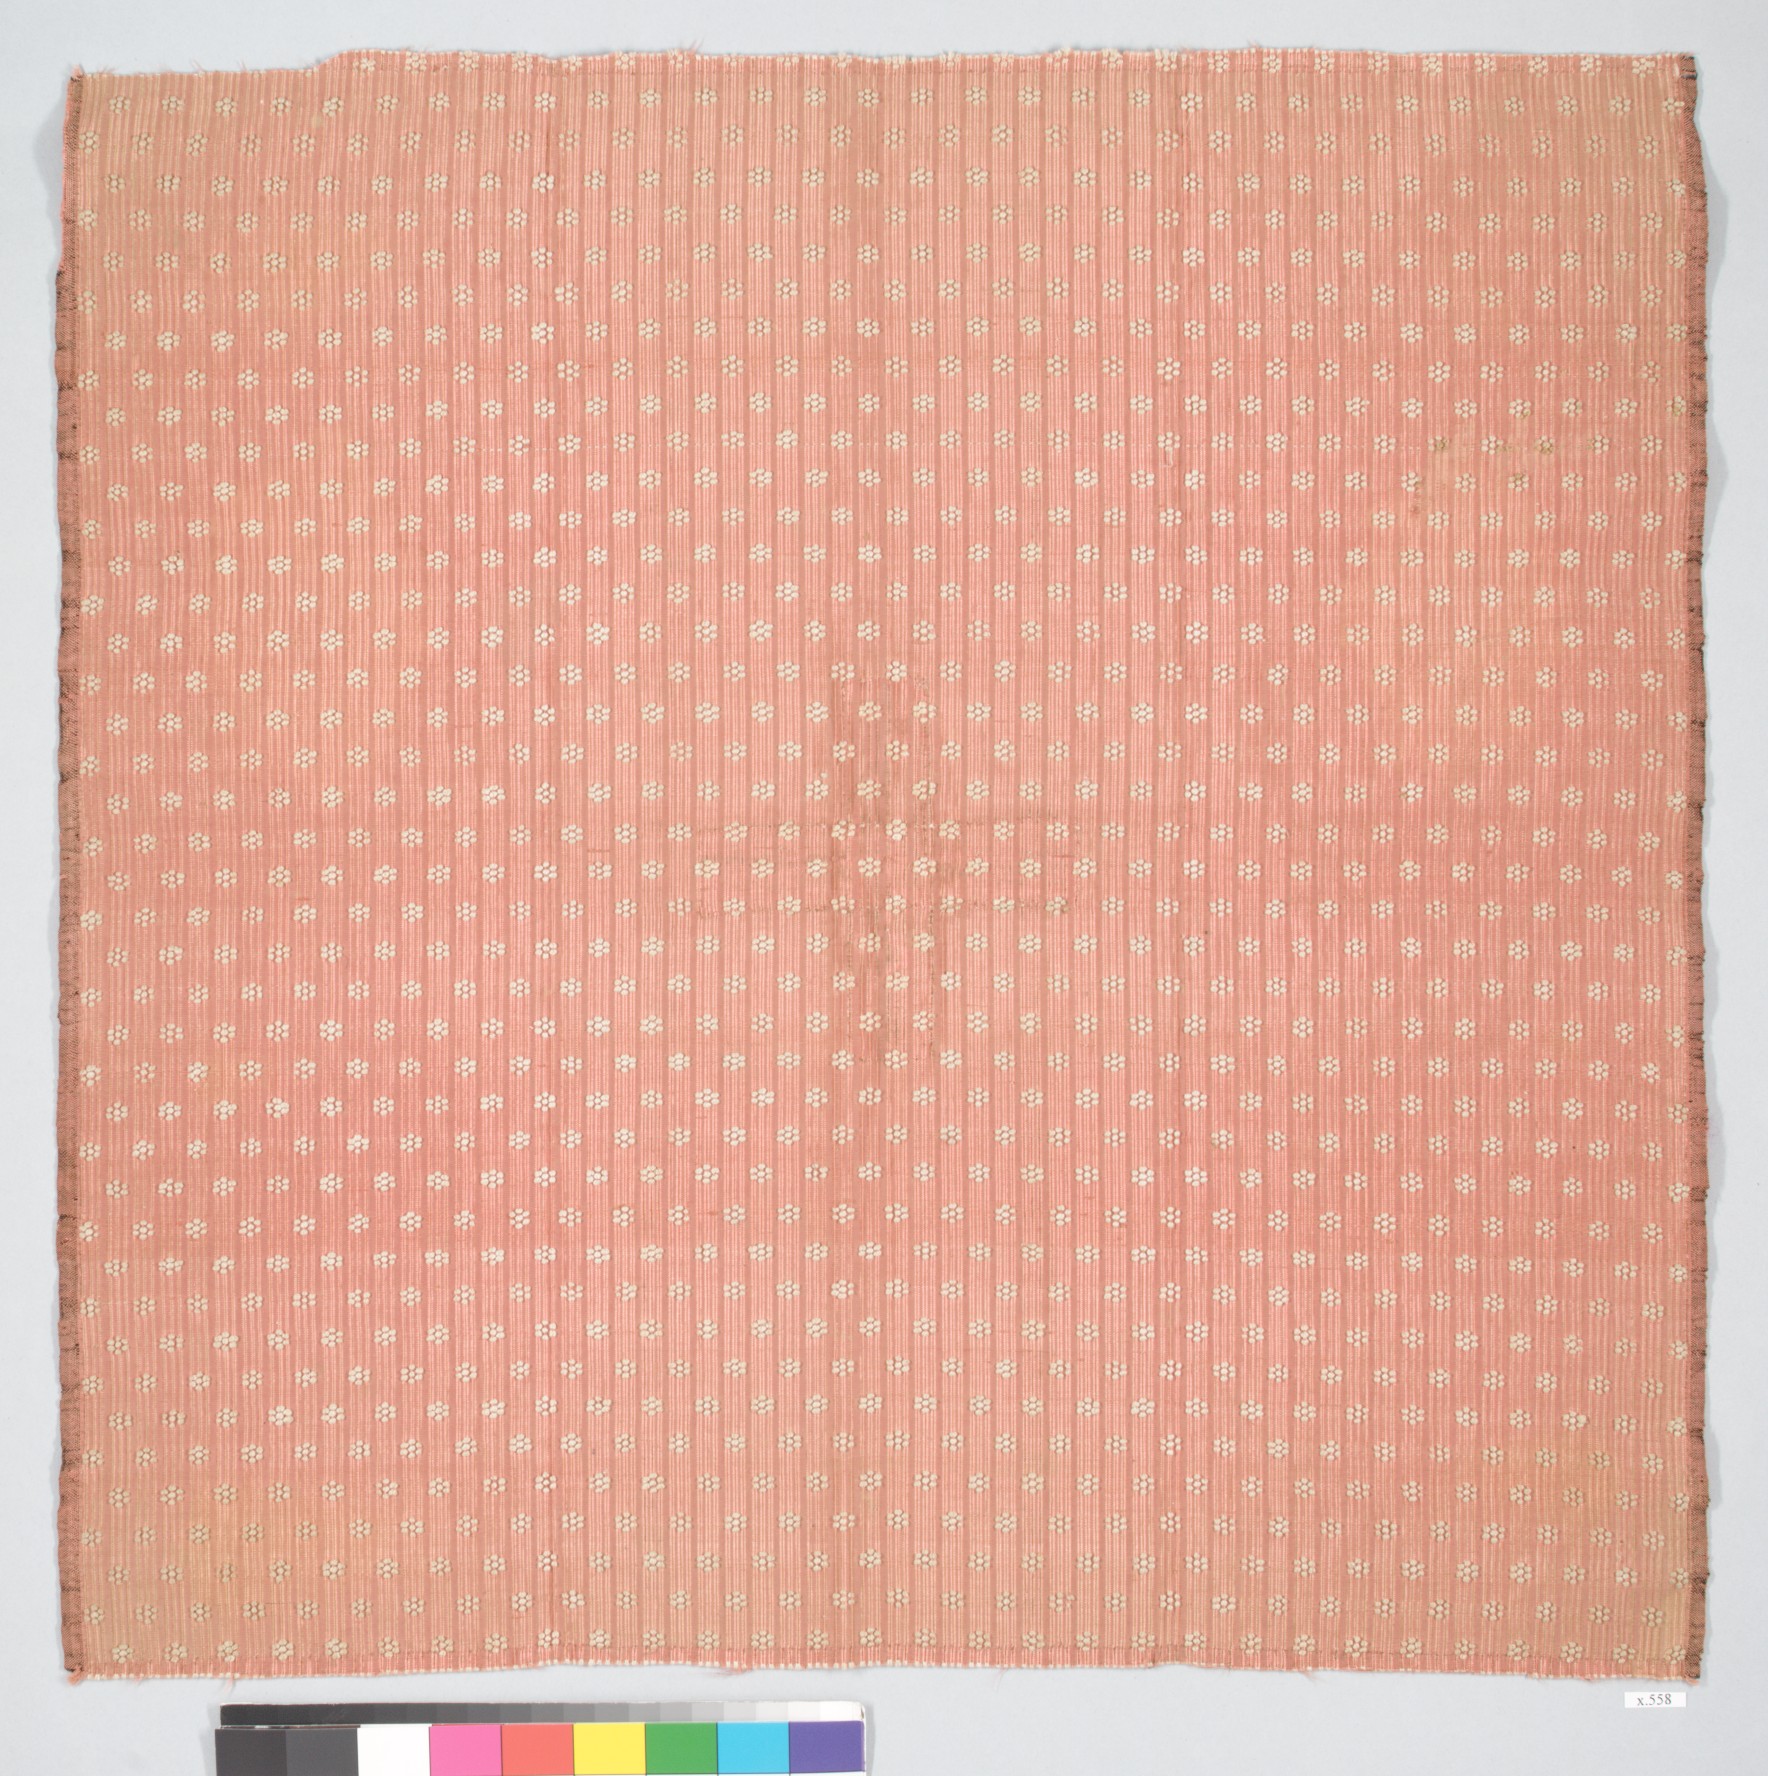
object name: piece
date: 1767-1833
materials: silk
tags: flowers